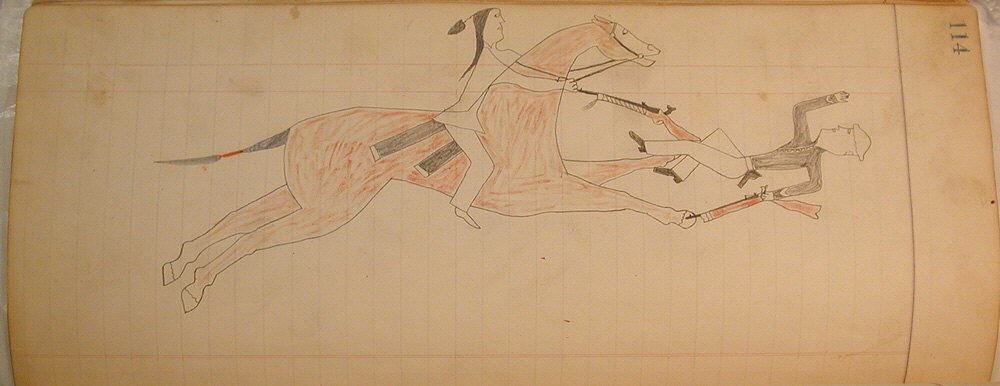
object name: drawing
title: Maffet Ledger: Drawing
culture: cheyenne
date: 1874-1881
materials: crayon, graphite, paper, watercolor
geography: united states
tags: firearms,men,horses